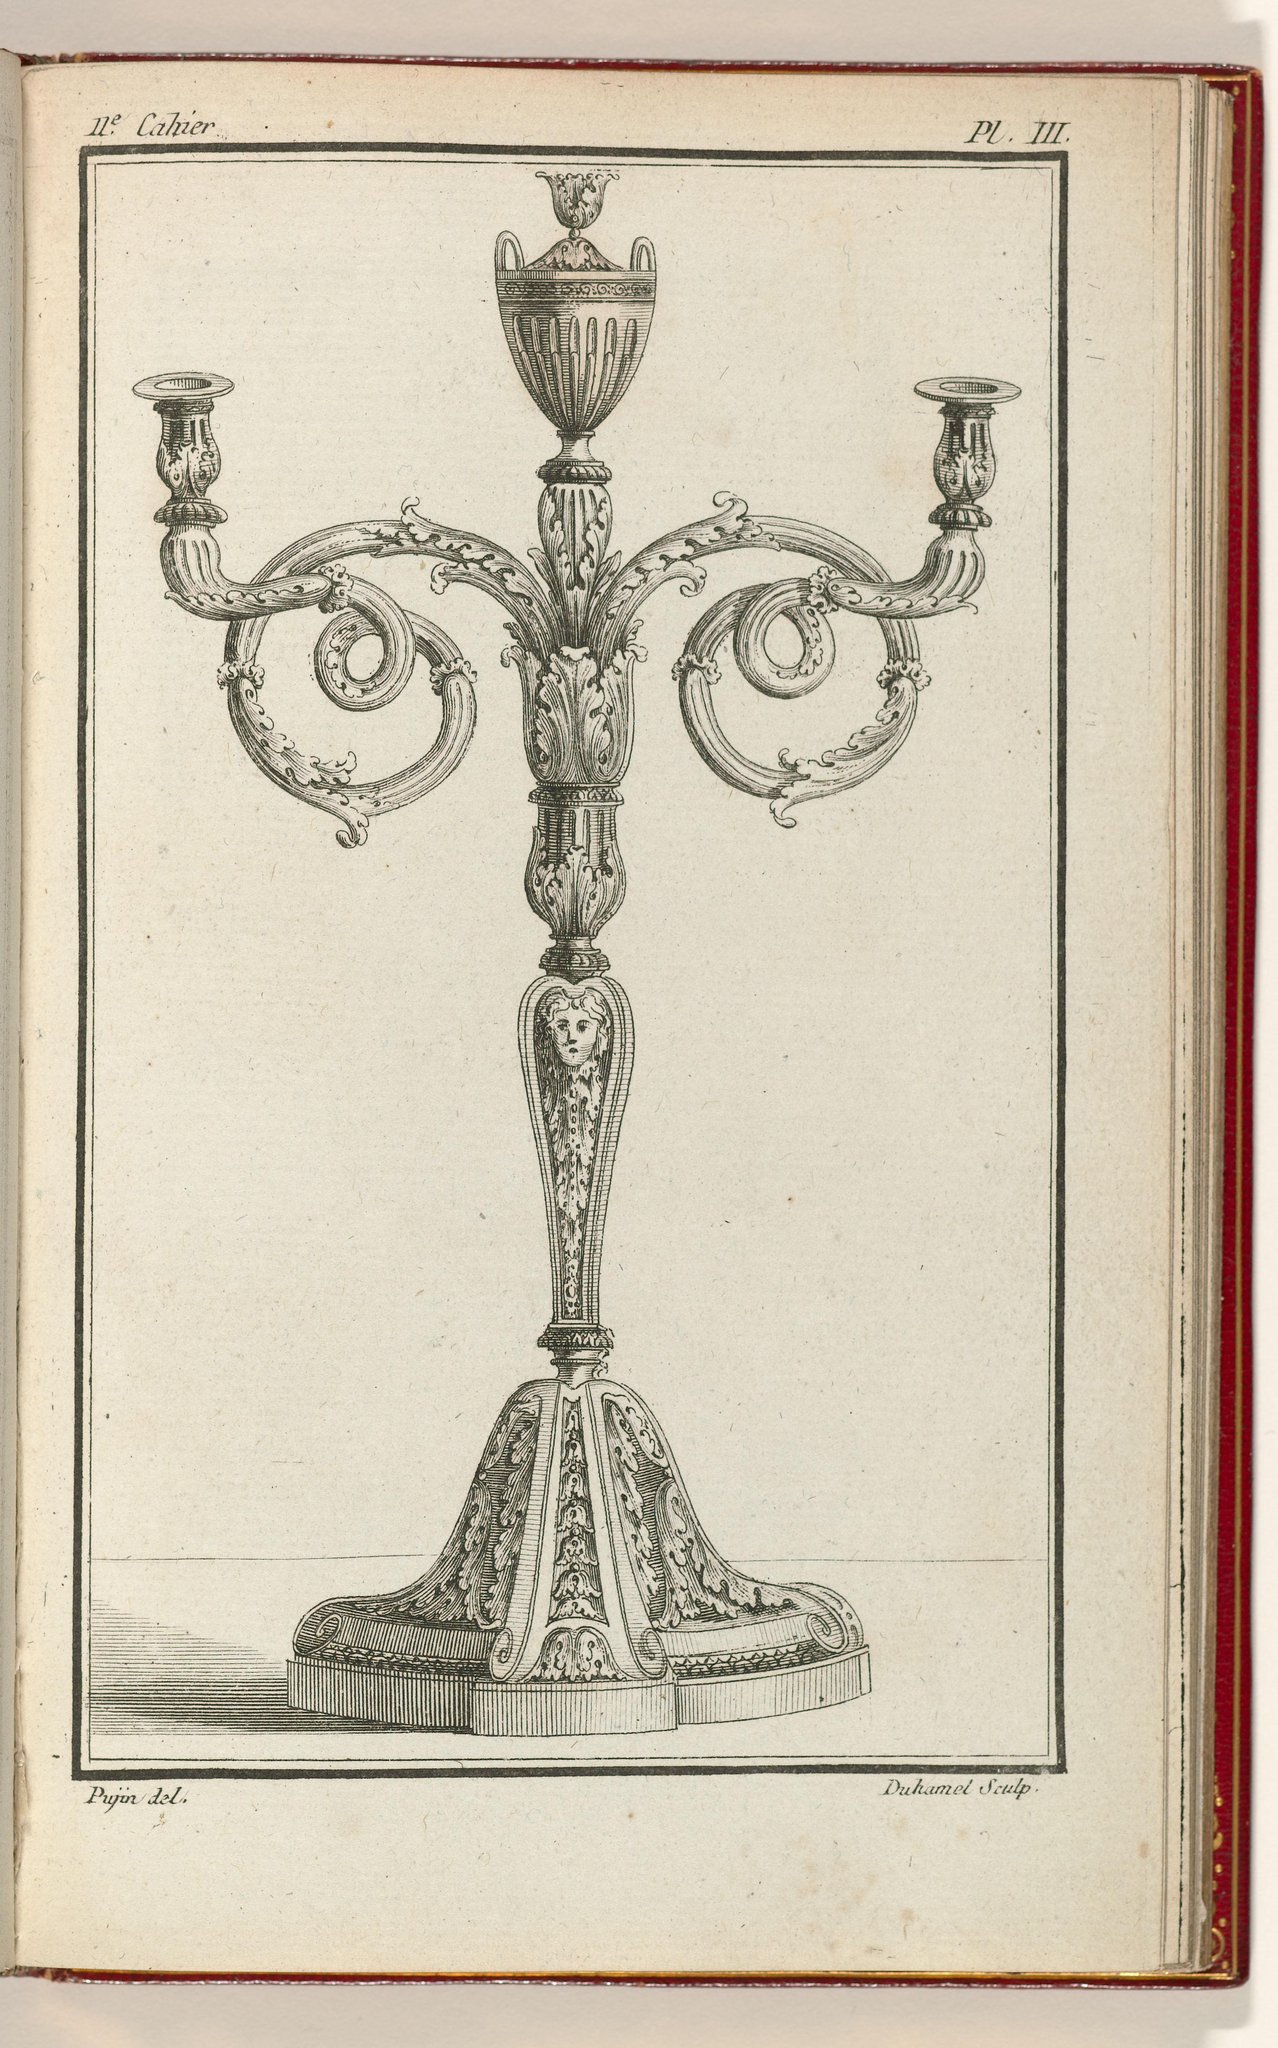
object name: print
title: Cabinet des Modes ou les Modes Nouvelles, 15 Avril 1786, pl. III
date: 1786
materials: paper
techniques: engraving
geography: paris